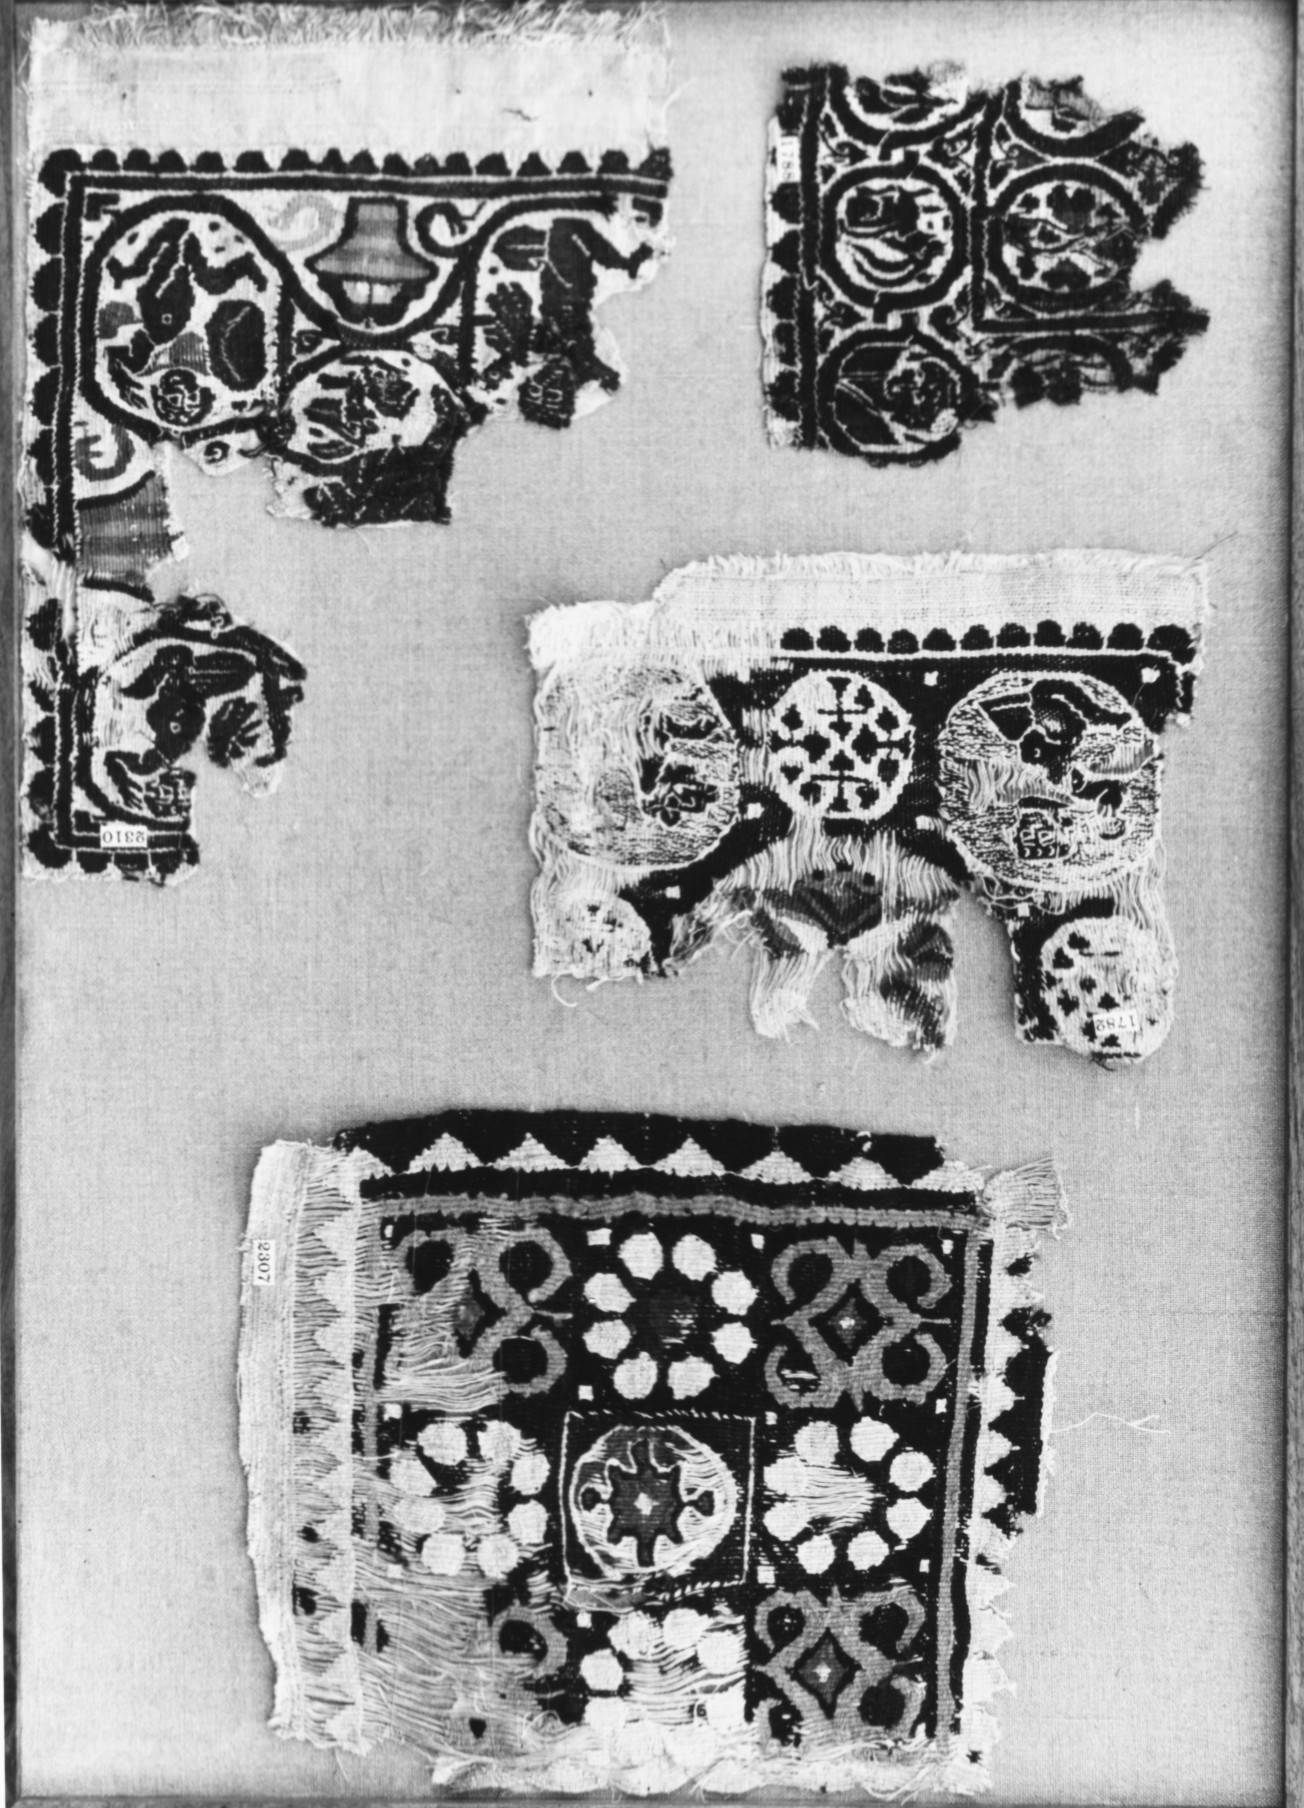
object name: square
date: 301-500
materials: linen, wool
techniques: weave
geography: egypt